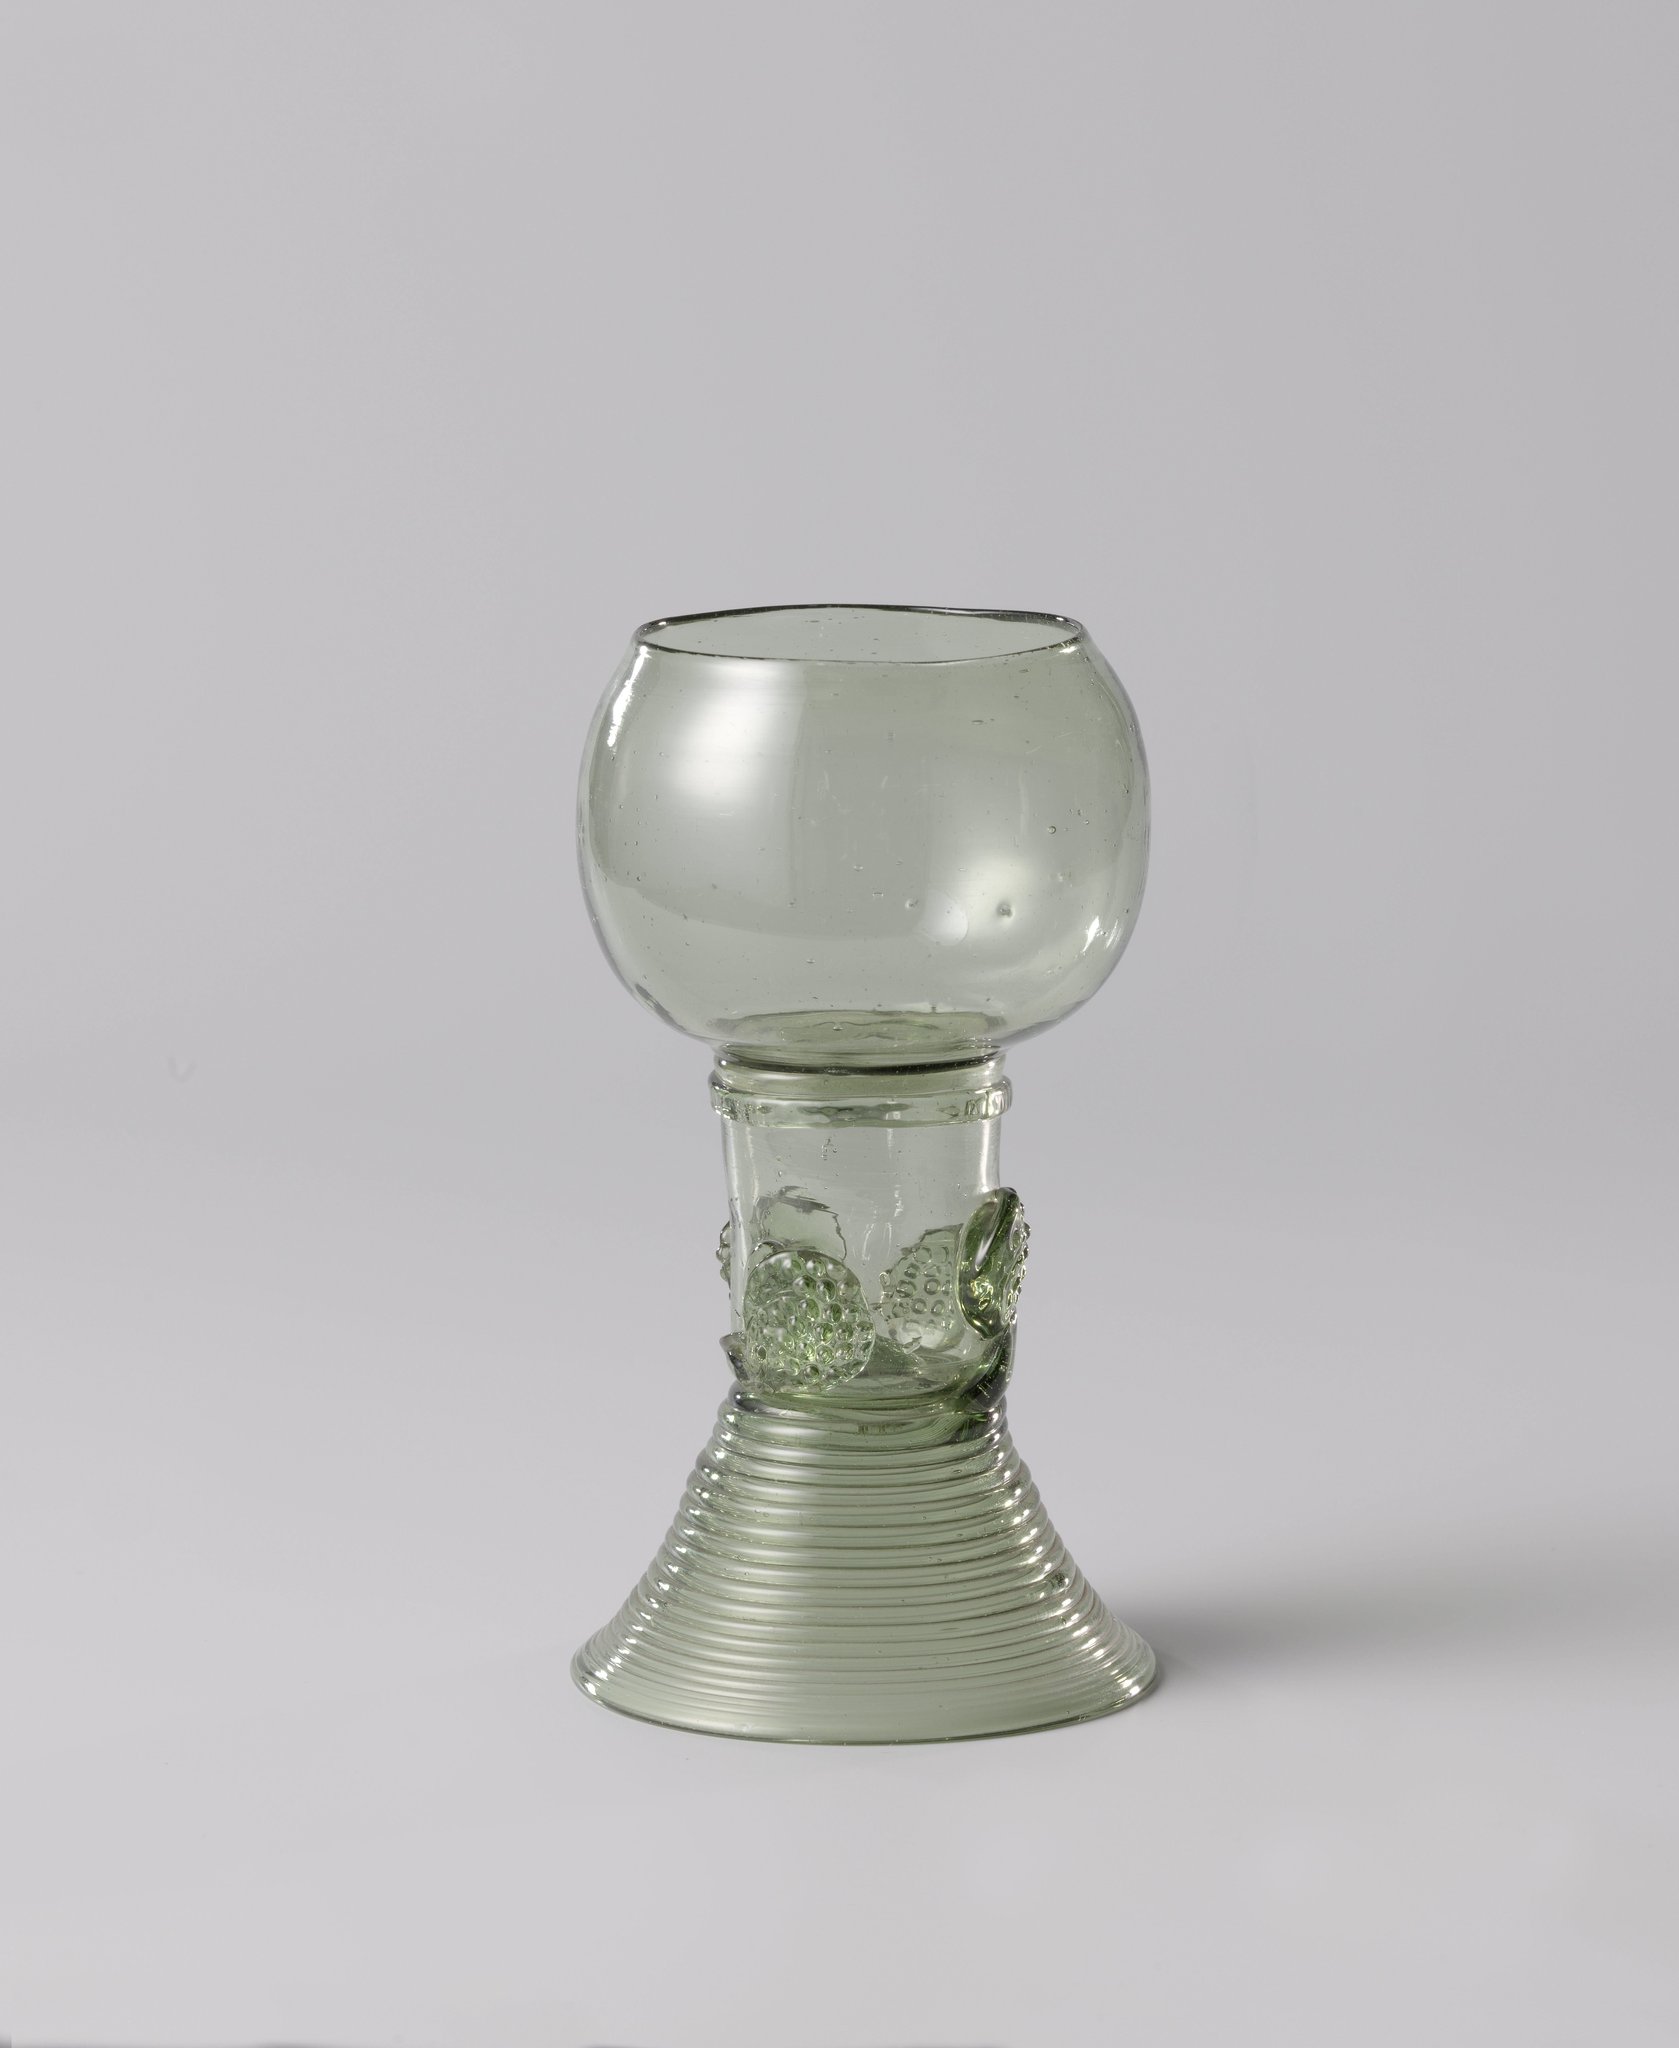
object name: roemer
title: Roemer met een rij braamnoppen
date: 1750-1810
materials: glass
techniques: glassblowing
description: Roemer op hoge, conische, uit een draad gesponnen voet. De bolvormige kelk en de stam, die bezet is met vier braamnoppen, zijn afzonderlijk geblazen. De overgang van de kelk naar de stam wordt aangegeven door een geribde draad